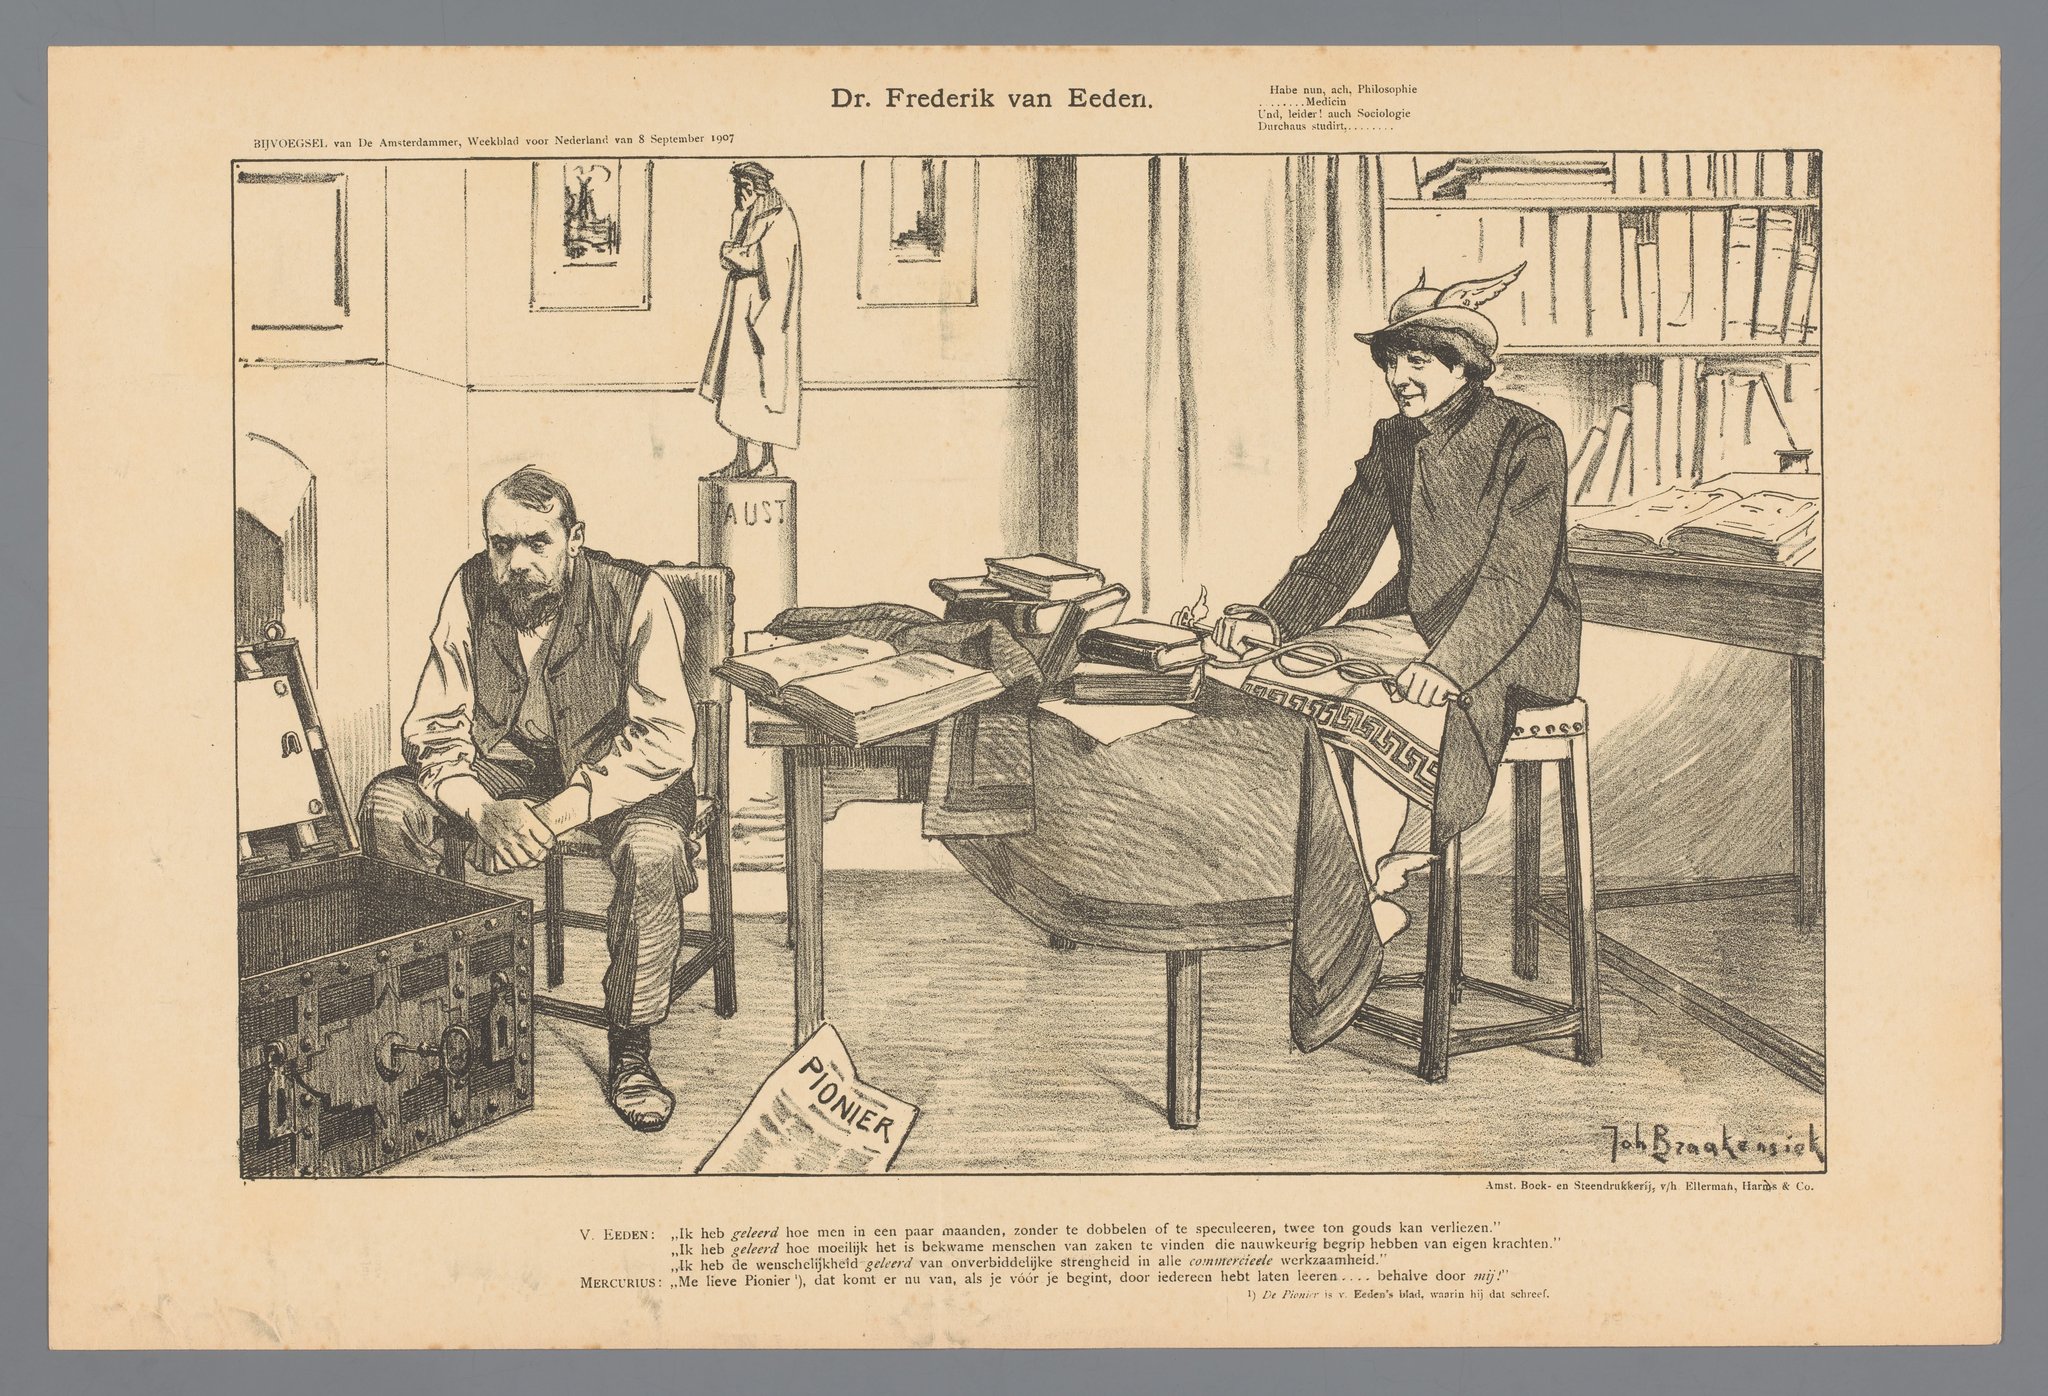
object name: cartoon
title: Dr. Frederik van Eeden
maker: johan braakensiek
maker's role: draughtsman, print maker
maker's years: 1858-1940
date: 1907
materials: paper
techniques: lithograph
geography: amsterdam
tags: haarlem, frederik van eeden, (story of) mercury (hermes), historical persons, political caricatures and satires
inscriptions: date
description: Prent uit het bijvoegsel van: De Amsterdammer. Weekblad voor Nederland, 8 september 1907.